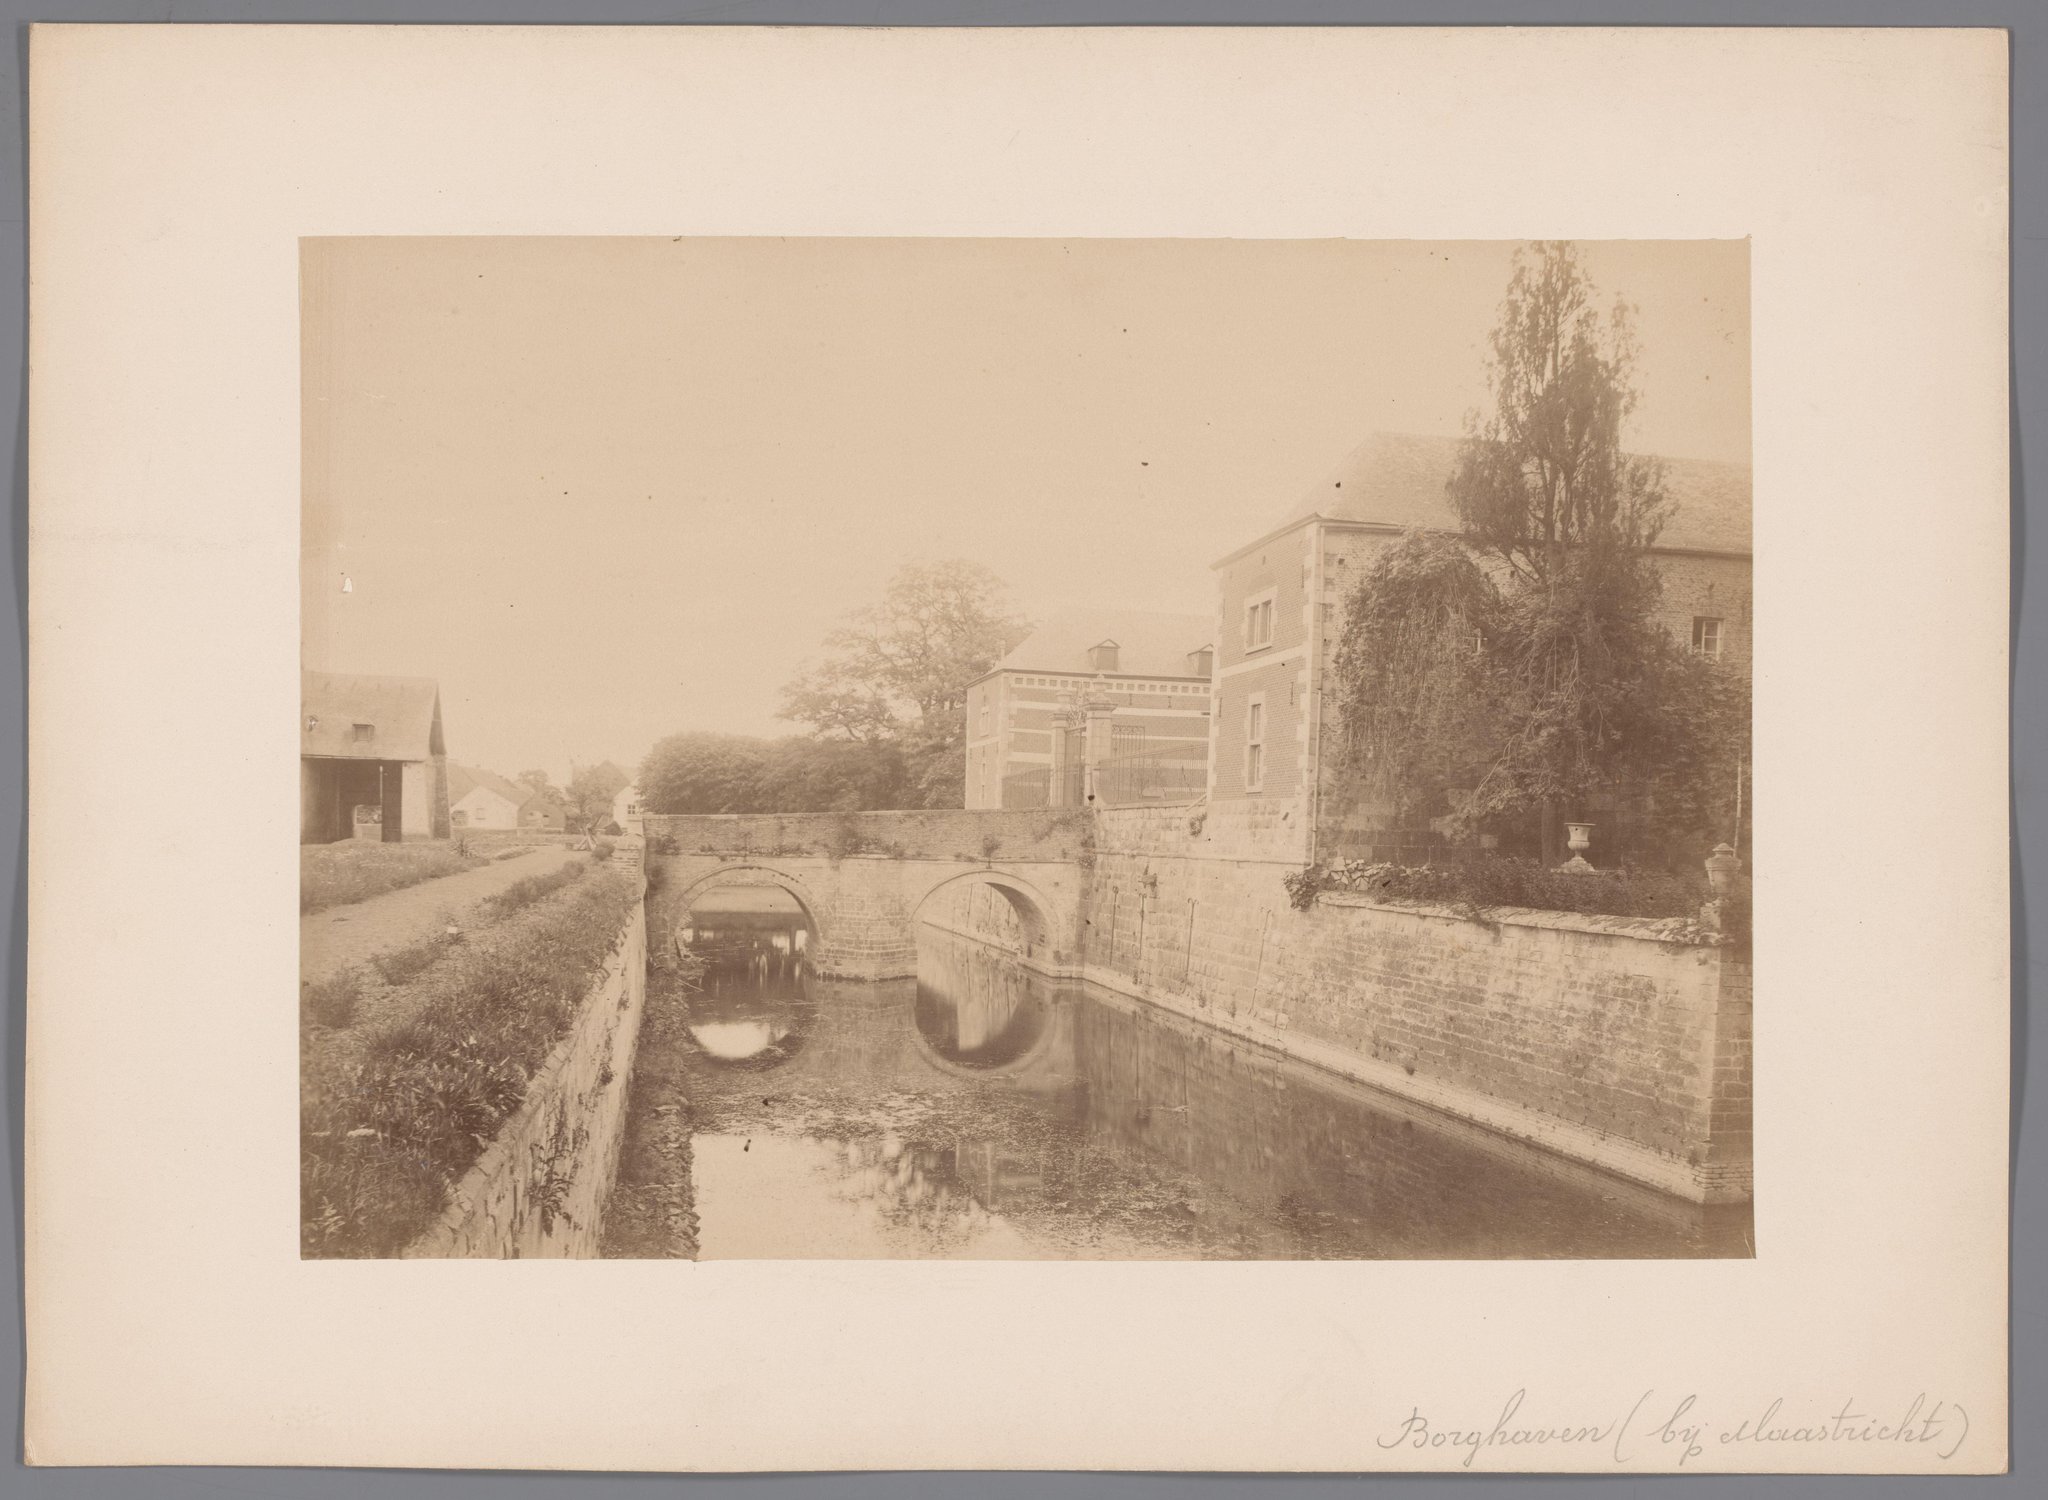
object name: photograph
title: Brug en slotgracht van Kasteel Borgharen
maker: raphaël baron de selys-longchamps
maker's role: fotograaf, luitenant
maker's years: 1841-1911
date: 1893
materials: cardboard, photographic support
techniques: albumen print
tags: moat ~ fortified city, castle, maastricht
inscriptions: annotation: ‘Kasteel te Borghaven bij Maastricht/ In 1893 na de restauratie’, annotation: ‘Borgharen (bij Maastricht)’